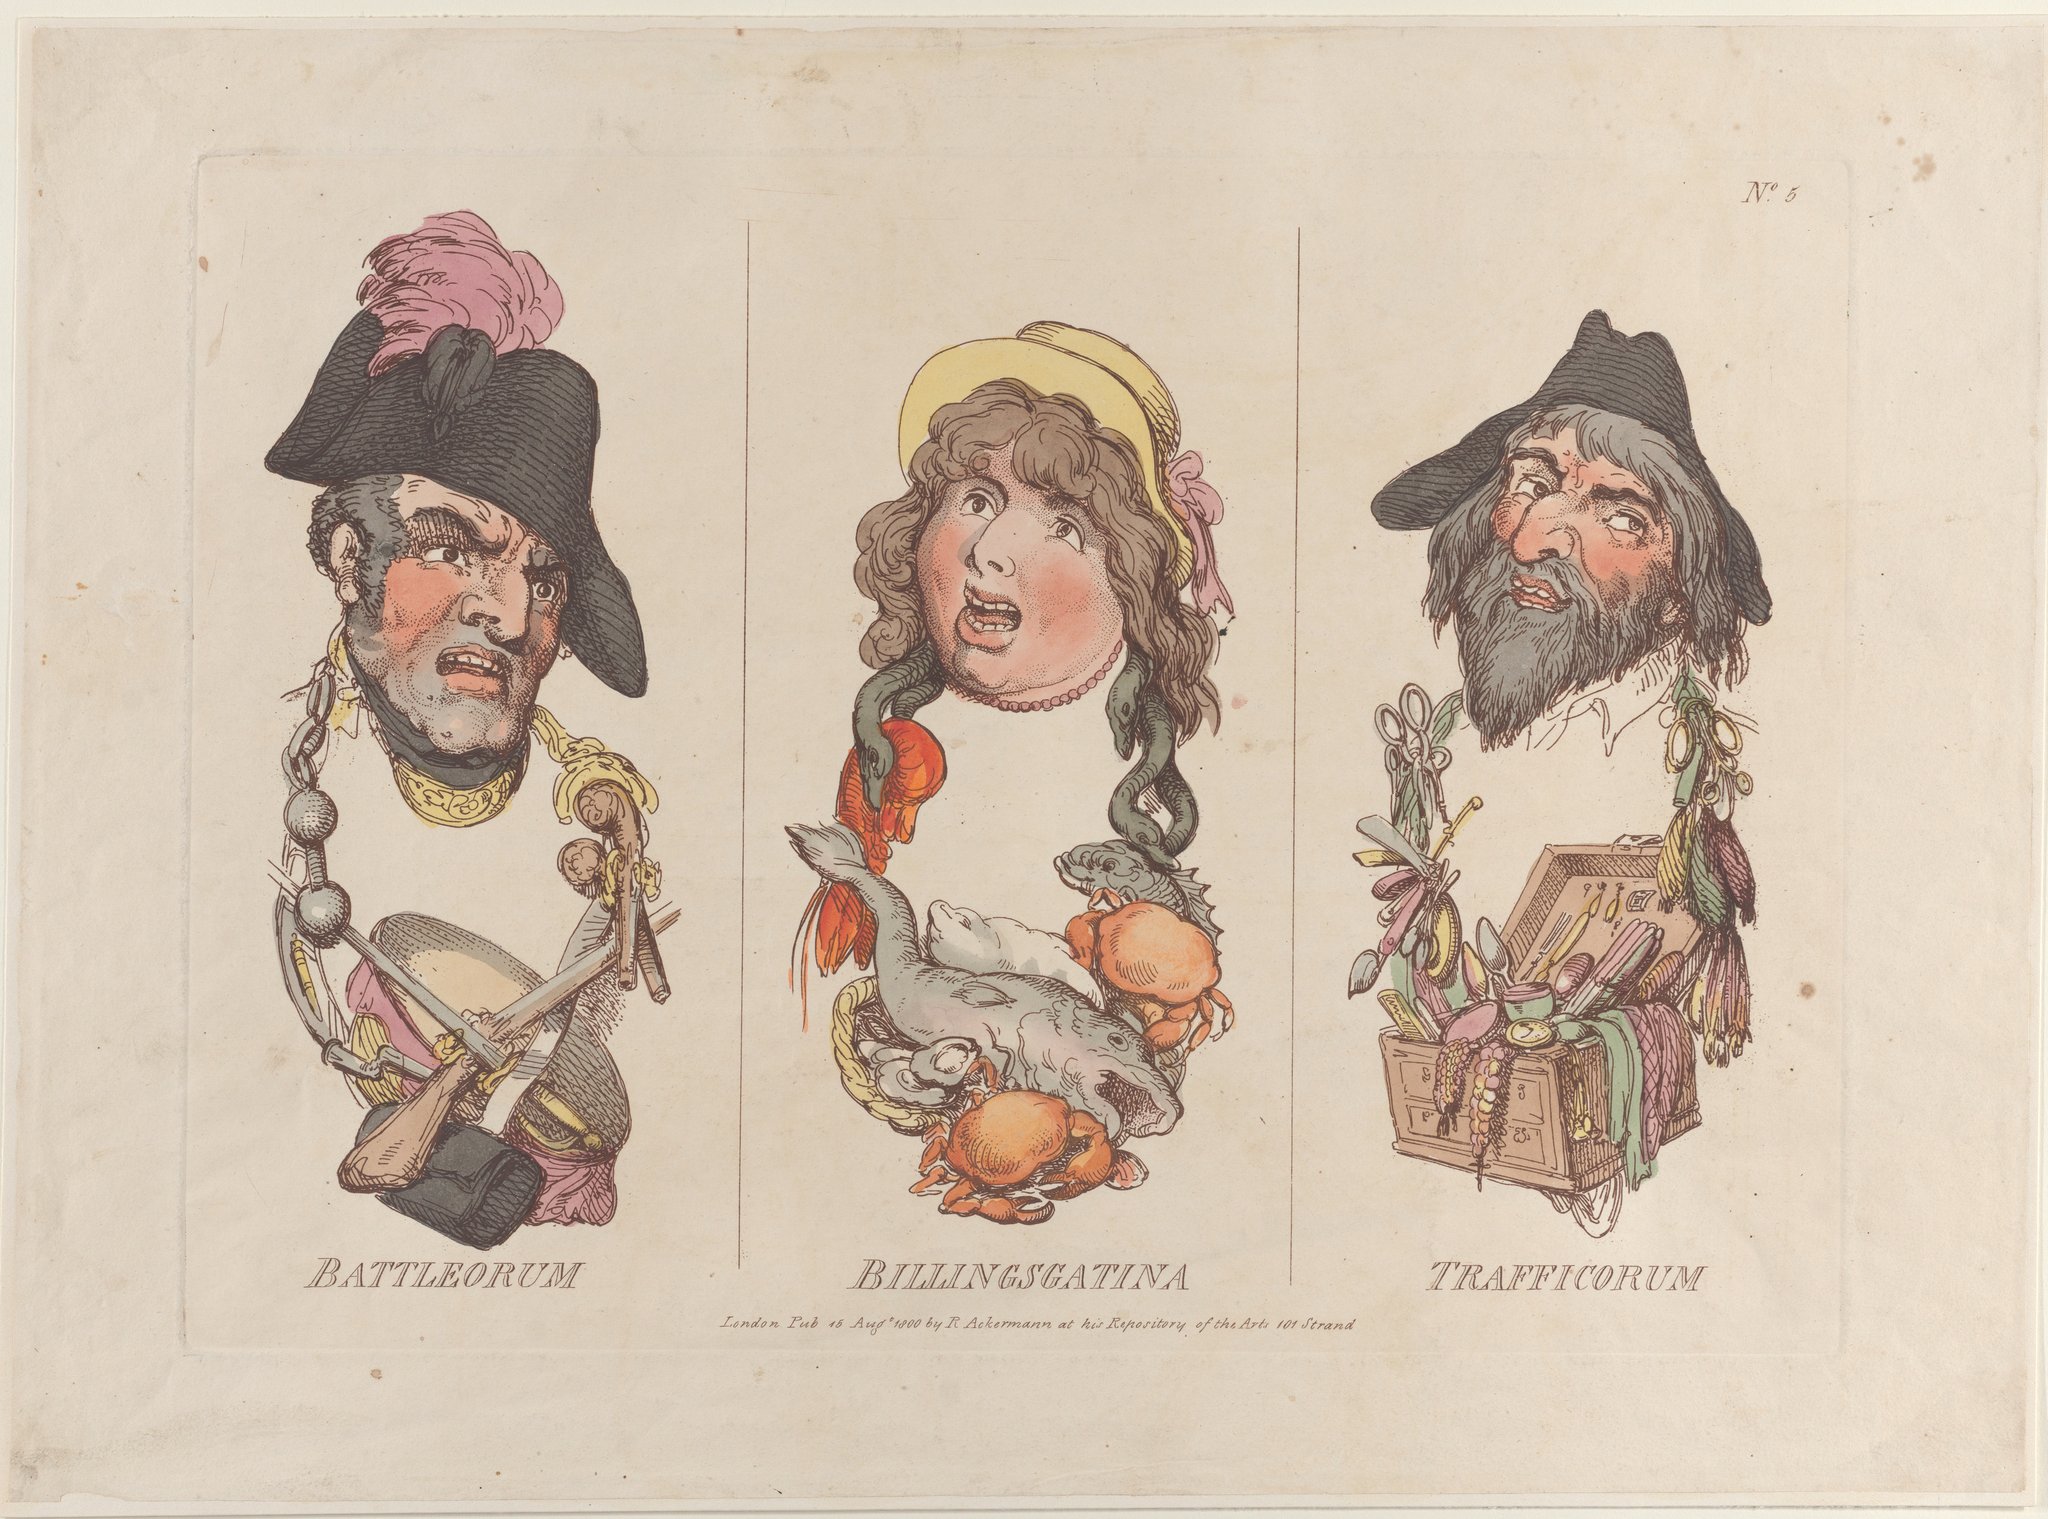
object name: print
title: Battleorum, Billingsgatina, Trafficorum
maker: thomas rowlandson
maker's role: artist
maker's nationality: british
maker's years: 1757-1827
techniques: etching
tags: satire,men,women